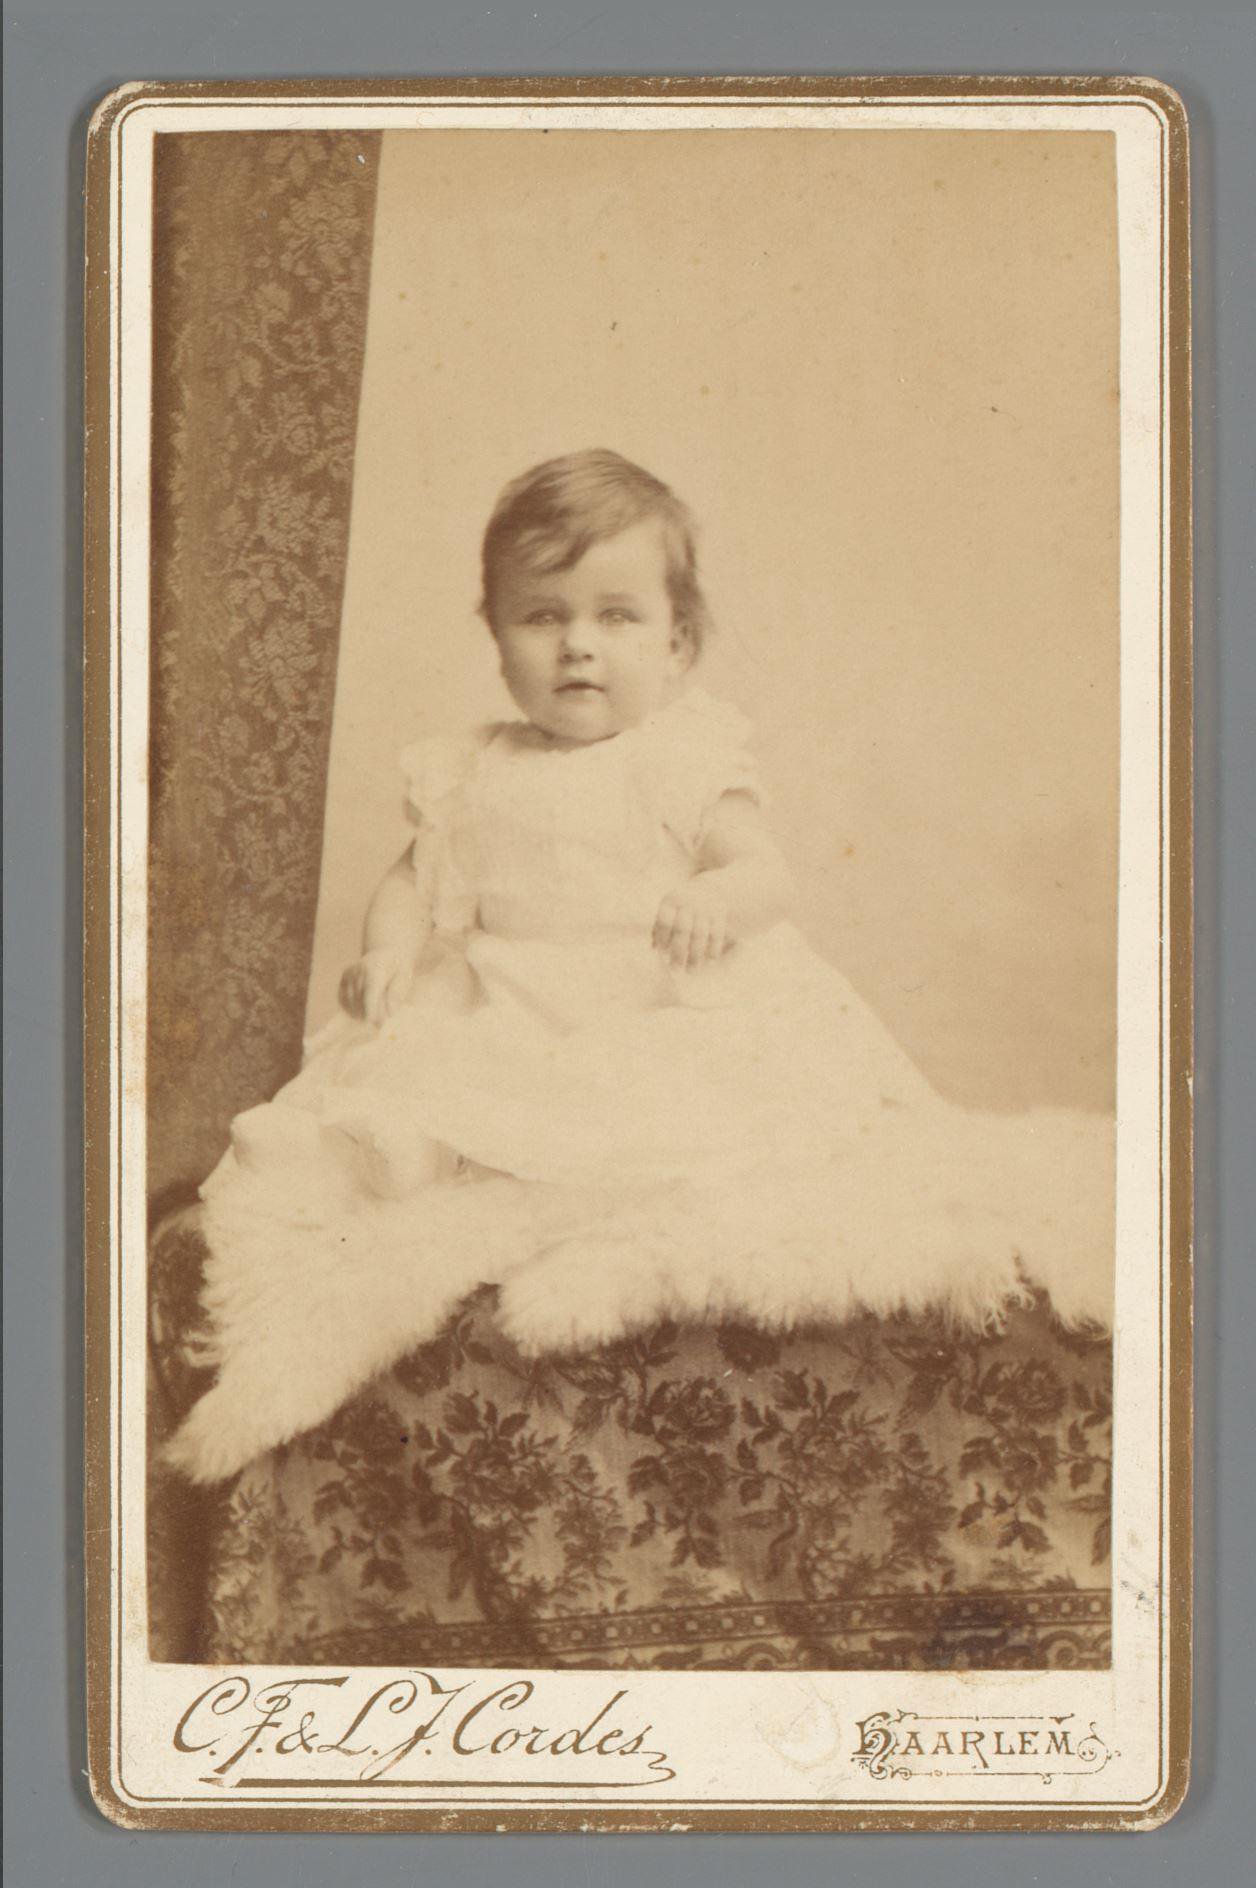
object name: carte de visite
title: Portret van Johanna Geertruida Jonker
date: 1895-1896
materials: cardboard, photographic support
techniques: albumen print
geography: haarlem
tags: historical persons, haarlem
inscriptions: annotation: ‘11 mnd./ hansje’, workshop stamp: ‘C.F. & L.J. Cordes/ Haarlem, Groote Houtstraat 84/ 's Bosch a/d. Parade’